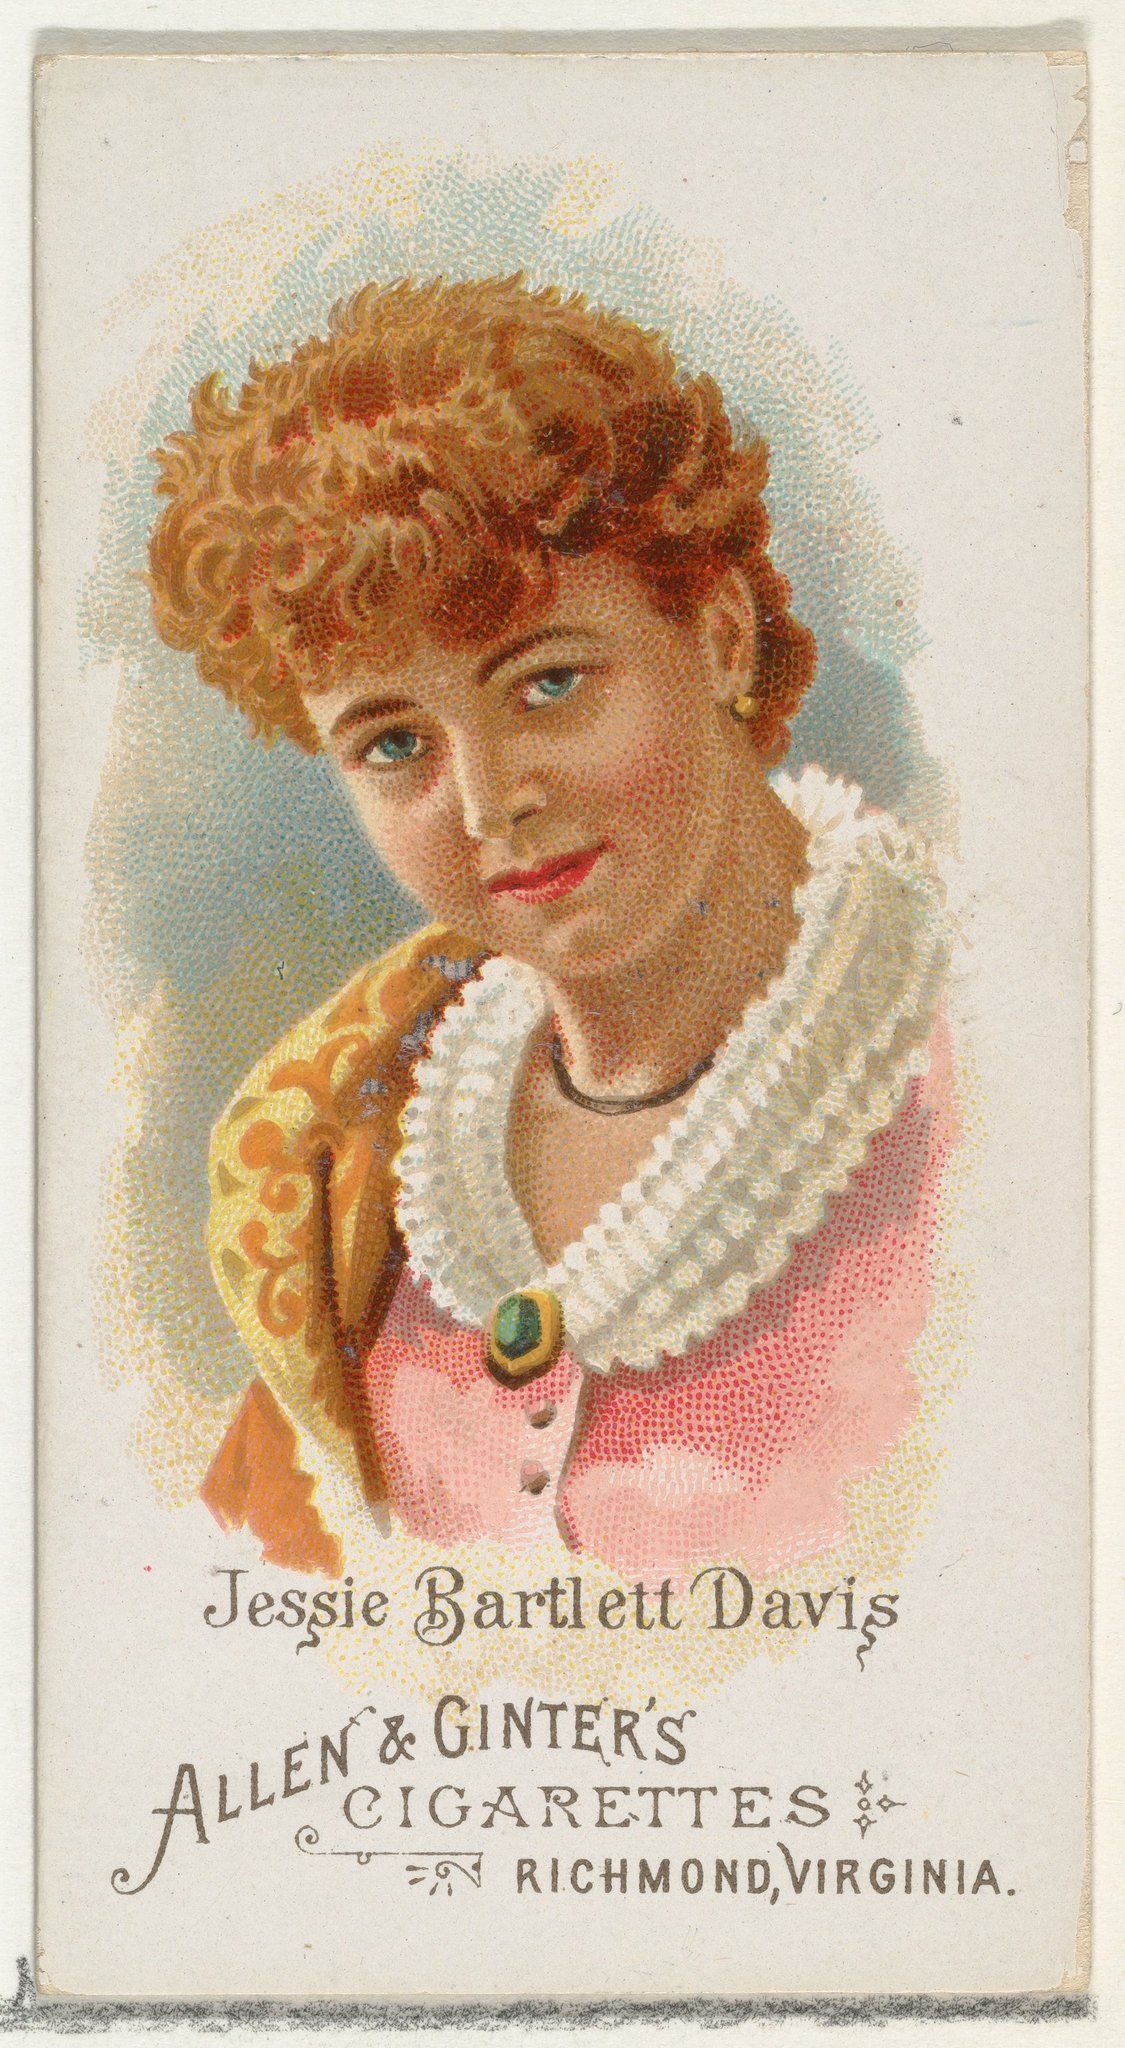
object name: print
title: Jessie Bartlett Davis, from World's Beauties, Series 1 (N26) for Allen & Ginter Cigarettes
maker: allen & ginter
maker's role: publisher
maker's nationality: american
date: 1888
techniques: color lithograph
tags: women